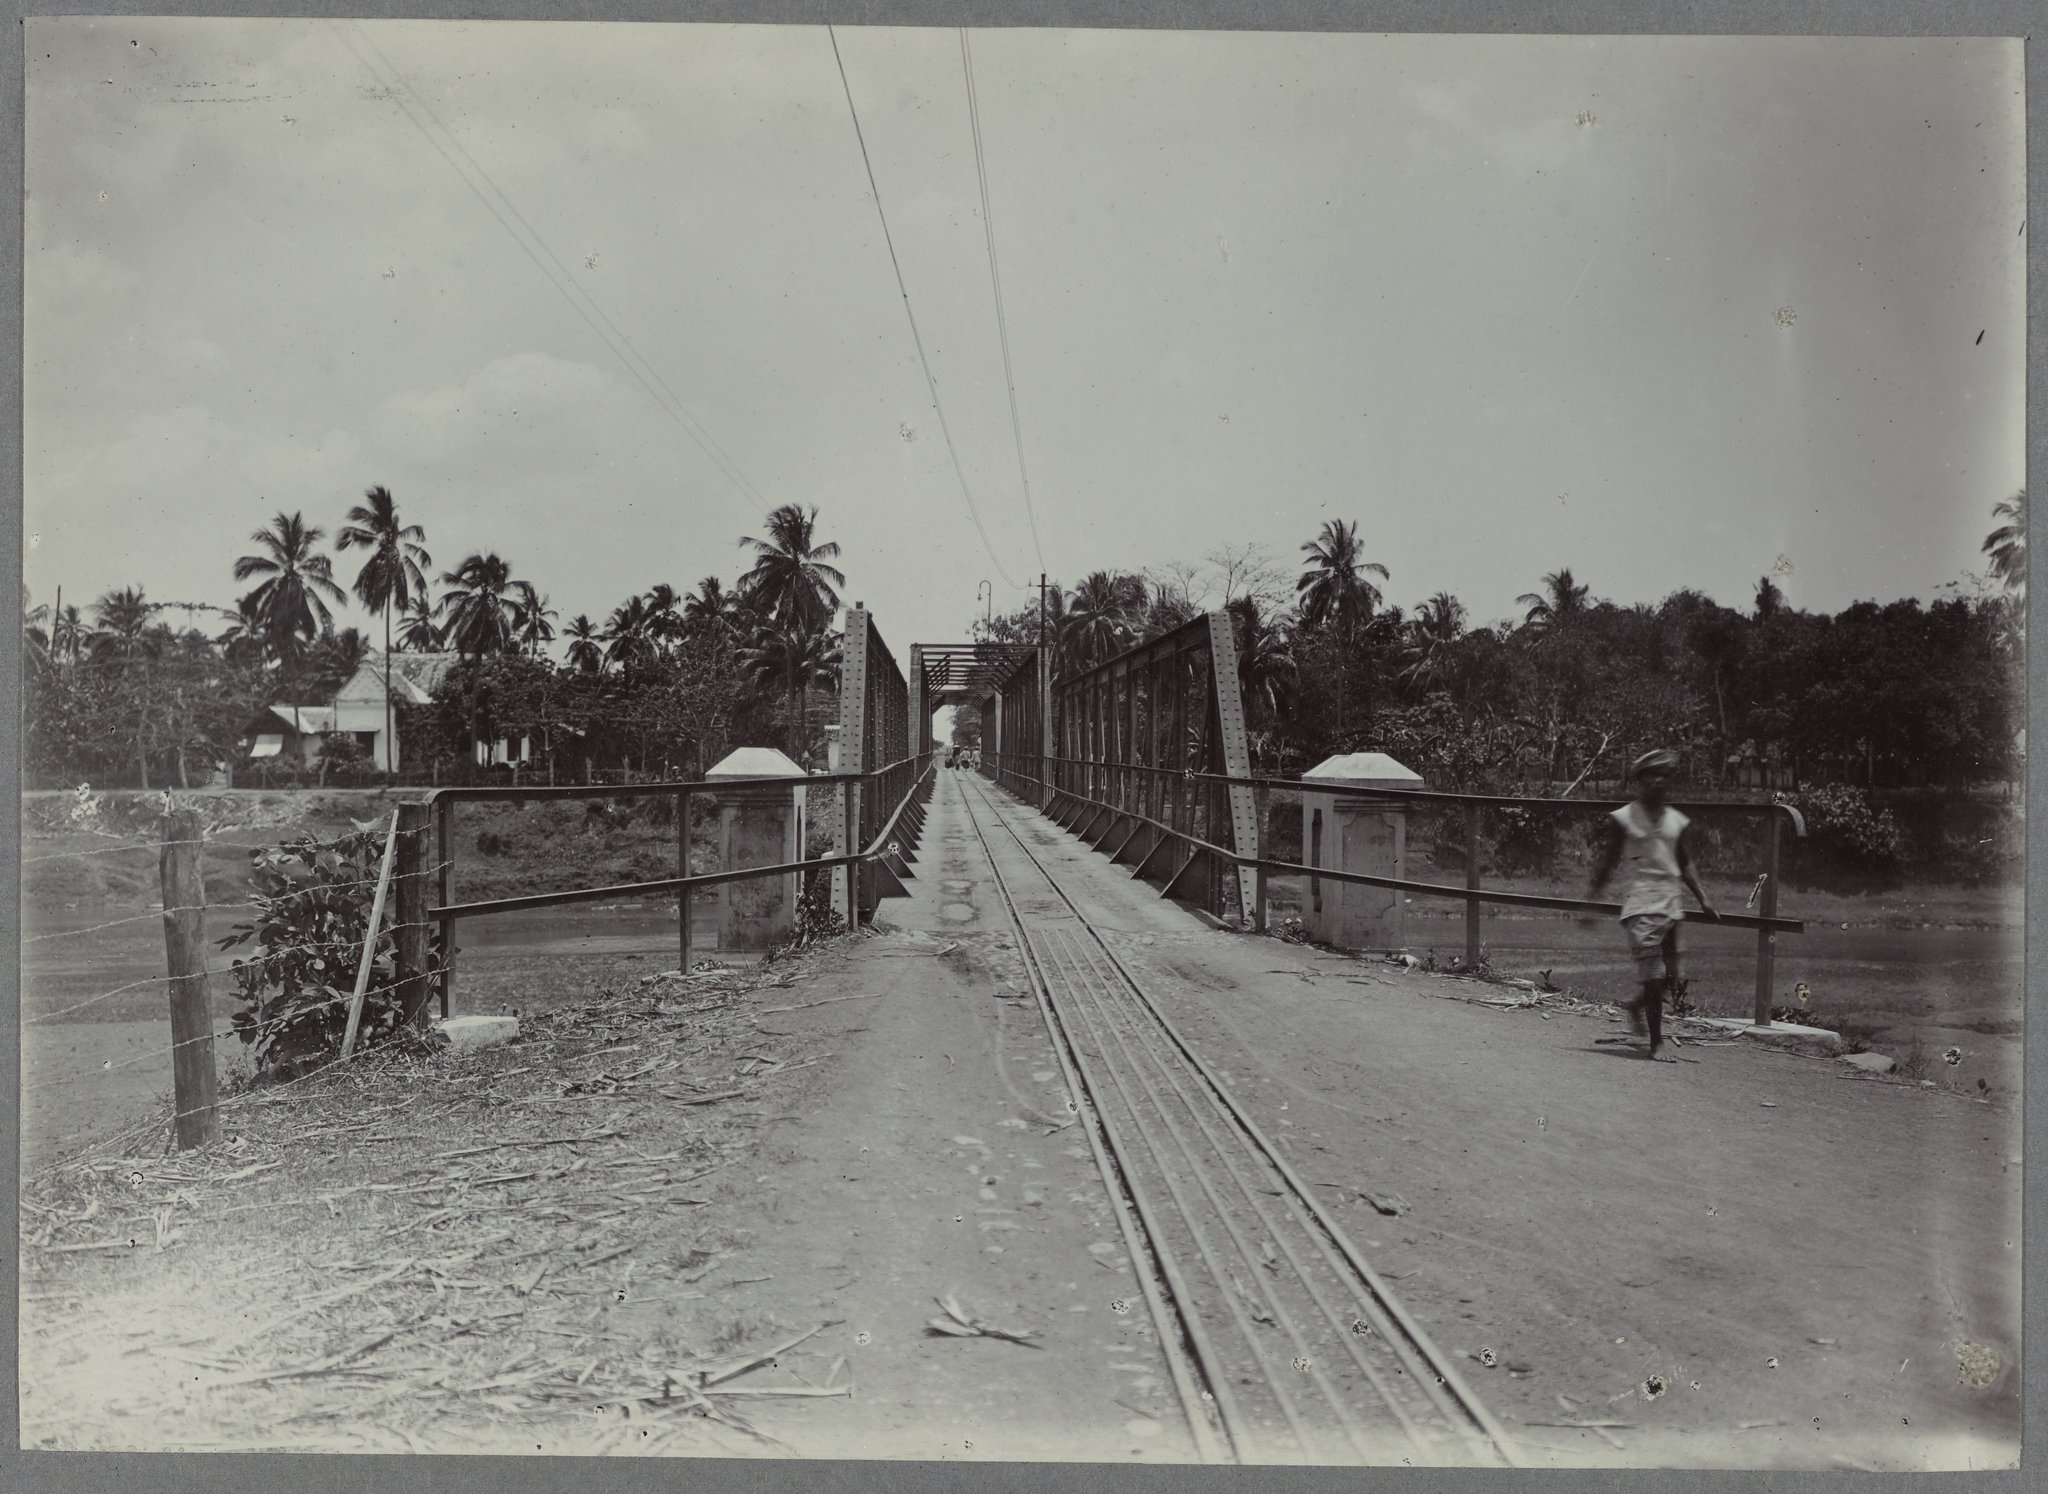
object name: photograph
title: Spoorbrug over een rivier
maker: Anonymous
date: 1900-1919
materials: photographic support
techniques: collodion silver print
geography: comal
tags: colonial system, railway-traffic, (non-fruit) products of plants or trees: sugarcane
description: Een spoorbrug over een rivier. Onderdeel van het fotoalbum van de Tjomal suikerfabriek in de periode ca. 1900-1919.